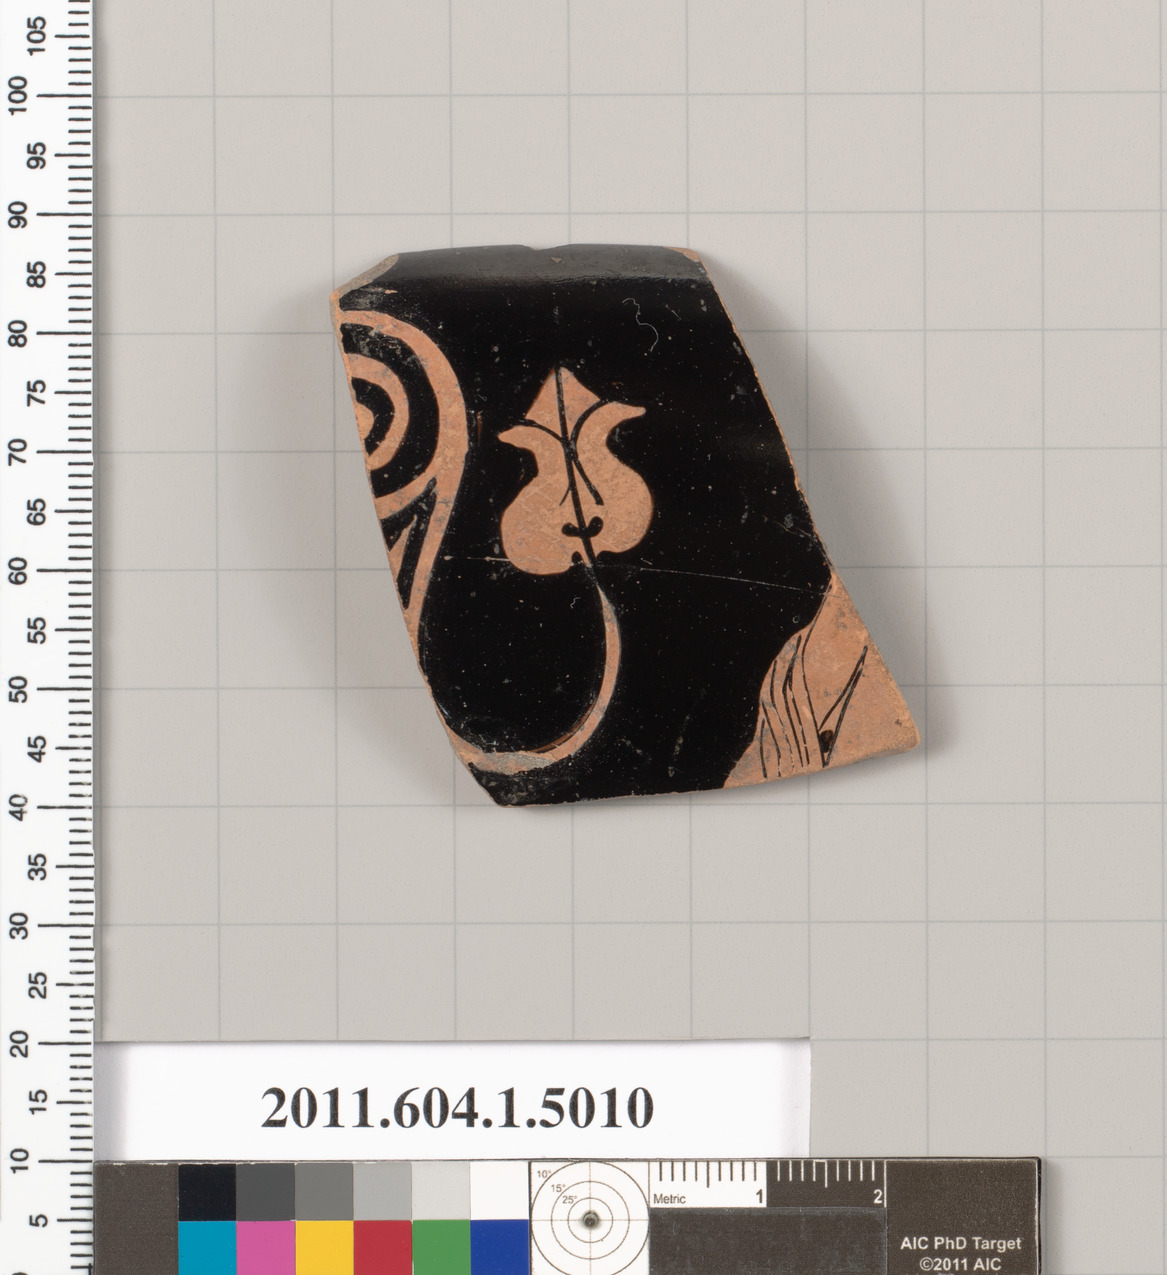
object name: kylix fragment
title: Terracotta rim fragment of a kylix (drinking cup)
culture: greek, attic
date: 475-451 BCE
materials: terracotta